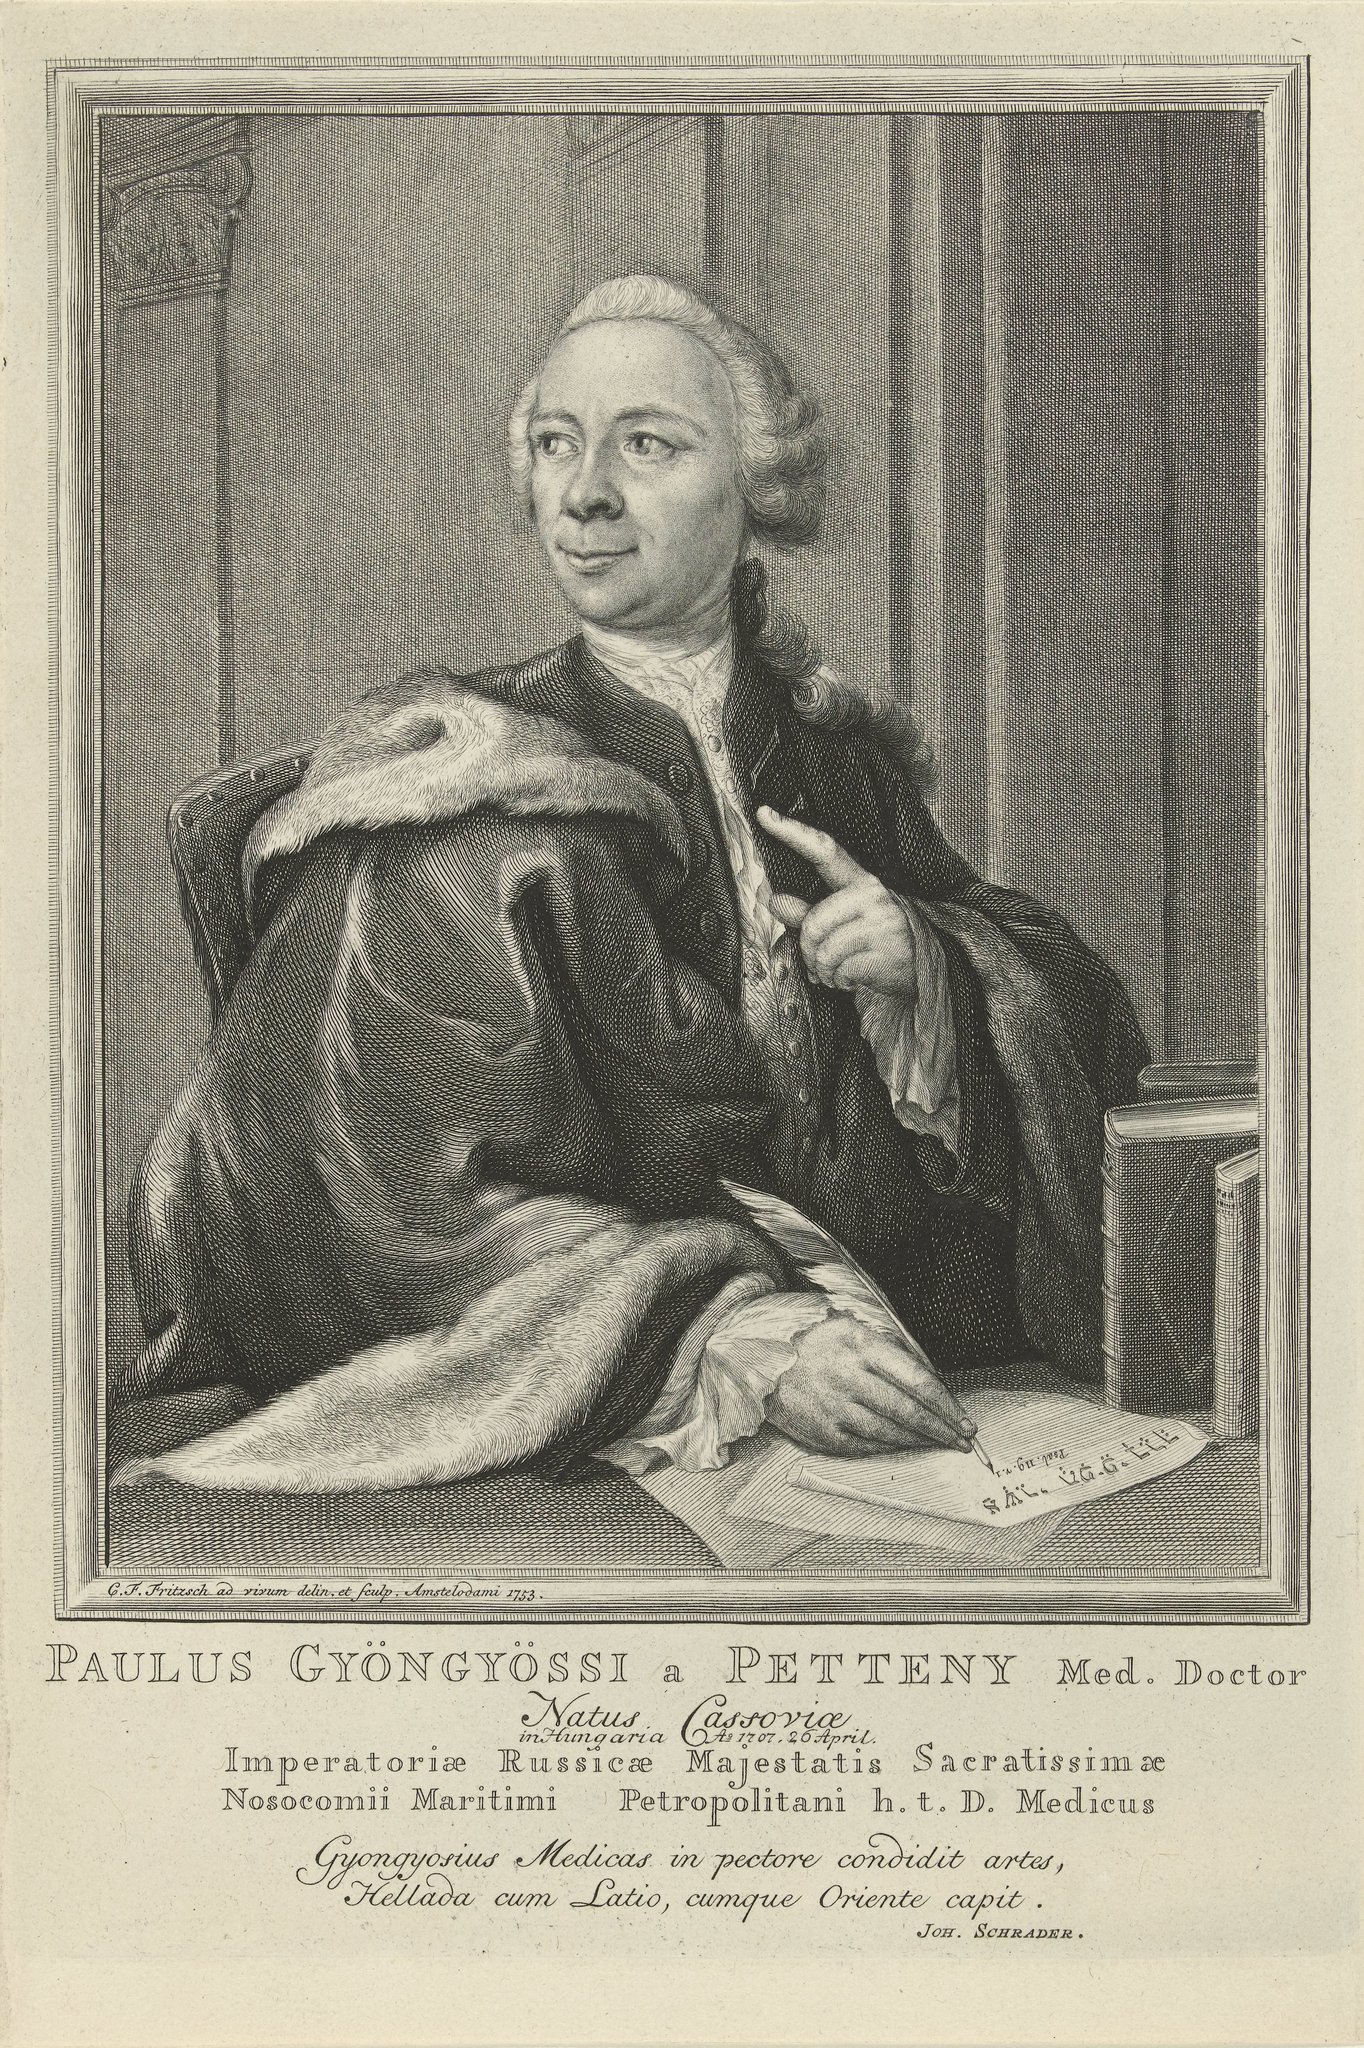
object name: print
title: Portret van Paulus Gyöngyösi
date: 1753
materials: paper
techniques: engraving, etching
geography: amsterdam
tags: letterkundige, paulus gyöngyösi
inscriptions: collector's mark: Lugt 240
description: De Hongaarse arts en letterkundige Paulus Gyöngyösi, schrijvend met een ganzenveer, zittend achter een bureau. Gyöngyösi kijkt naar links, met opgeheven vinger. Onder het portret staan onder zijn naam en titels vier regels tekst, geheel in het Latijn.